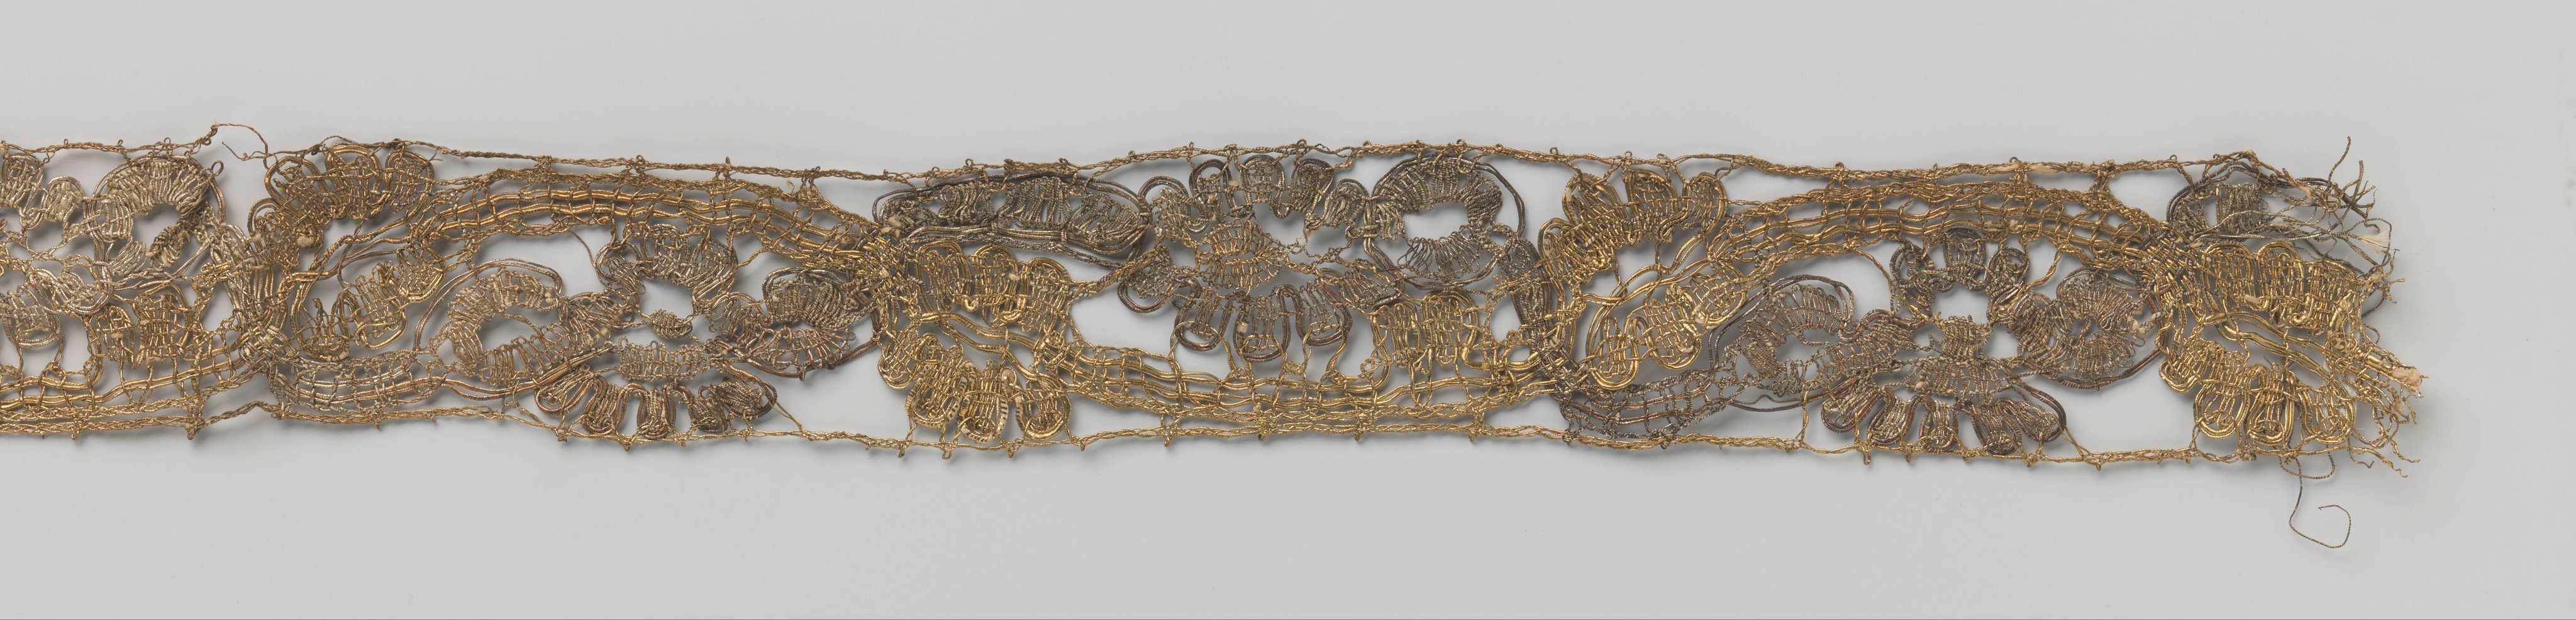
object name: strip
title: Strook goudkant en zilverkant met oversnijdende ranken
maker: Anonymous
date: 1700-1799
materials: gold thread, silk, thread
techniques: lace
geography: france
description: Strook gekloste goud- en zilverkant. Het patroon bestaat uit een doorlopende golvende rank met vóór en ná elke golftop een bloem met zeven lobben, gemaakt in gouddraad. Deze gouden rank wordt oversneden door een golvende zilveren rank, met daaraan een aaneenschakeling van een cirkelvormig, een gelobd en een min of meer ovaalvormig motief. Afwisselend is in het centrum van het gelobde motief een goudkleurig ovaal centrum en een hoekig zilverkleurig centrum gemaakt. De motieven zijn voornamelijk gemaakt in vormslag en in linnenslag, met dikkere contourdraden en gevlochten contourlijnen. Boven- en onderzijde van de strook zijn recht afgewerkt, met weinig picots.